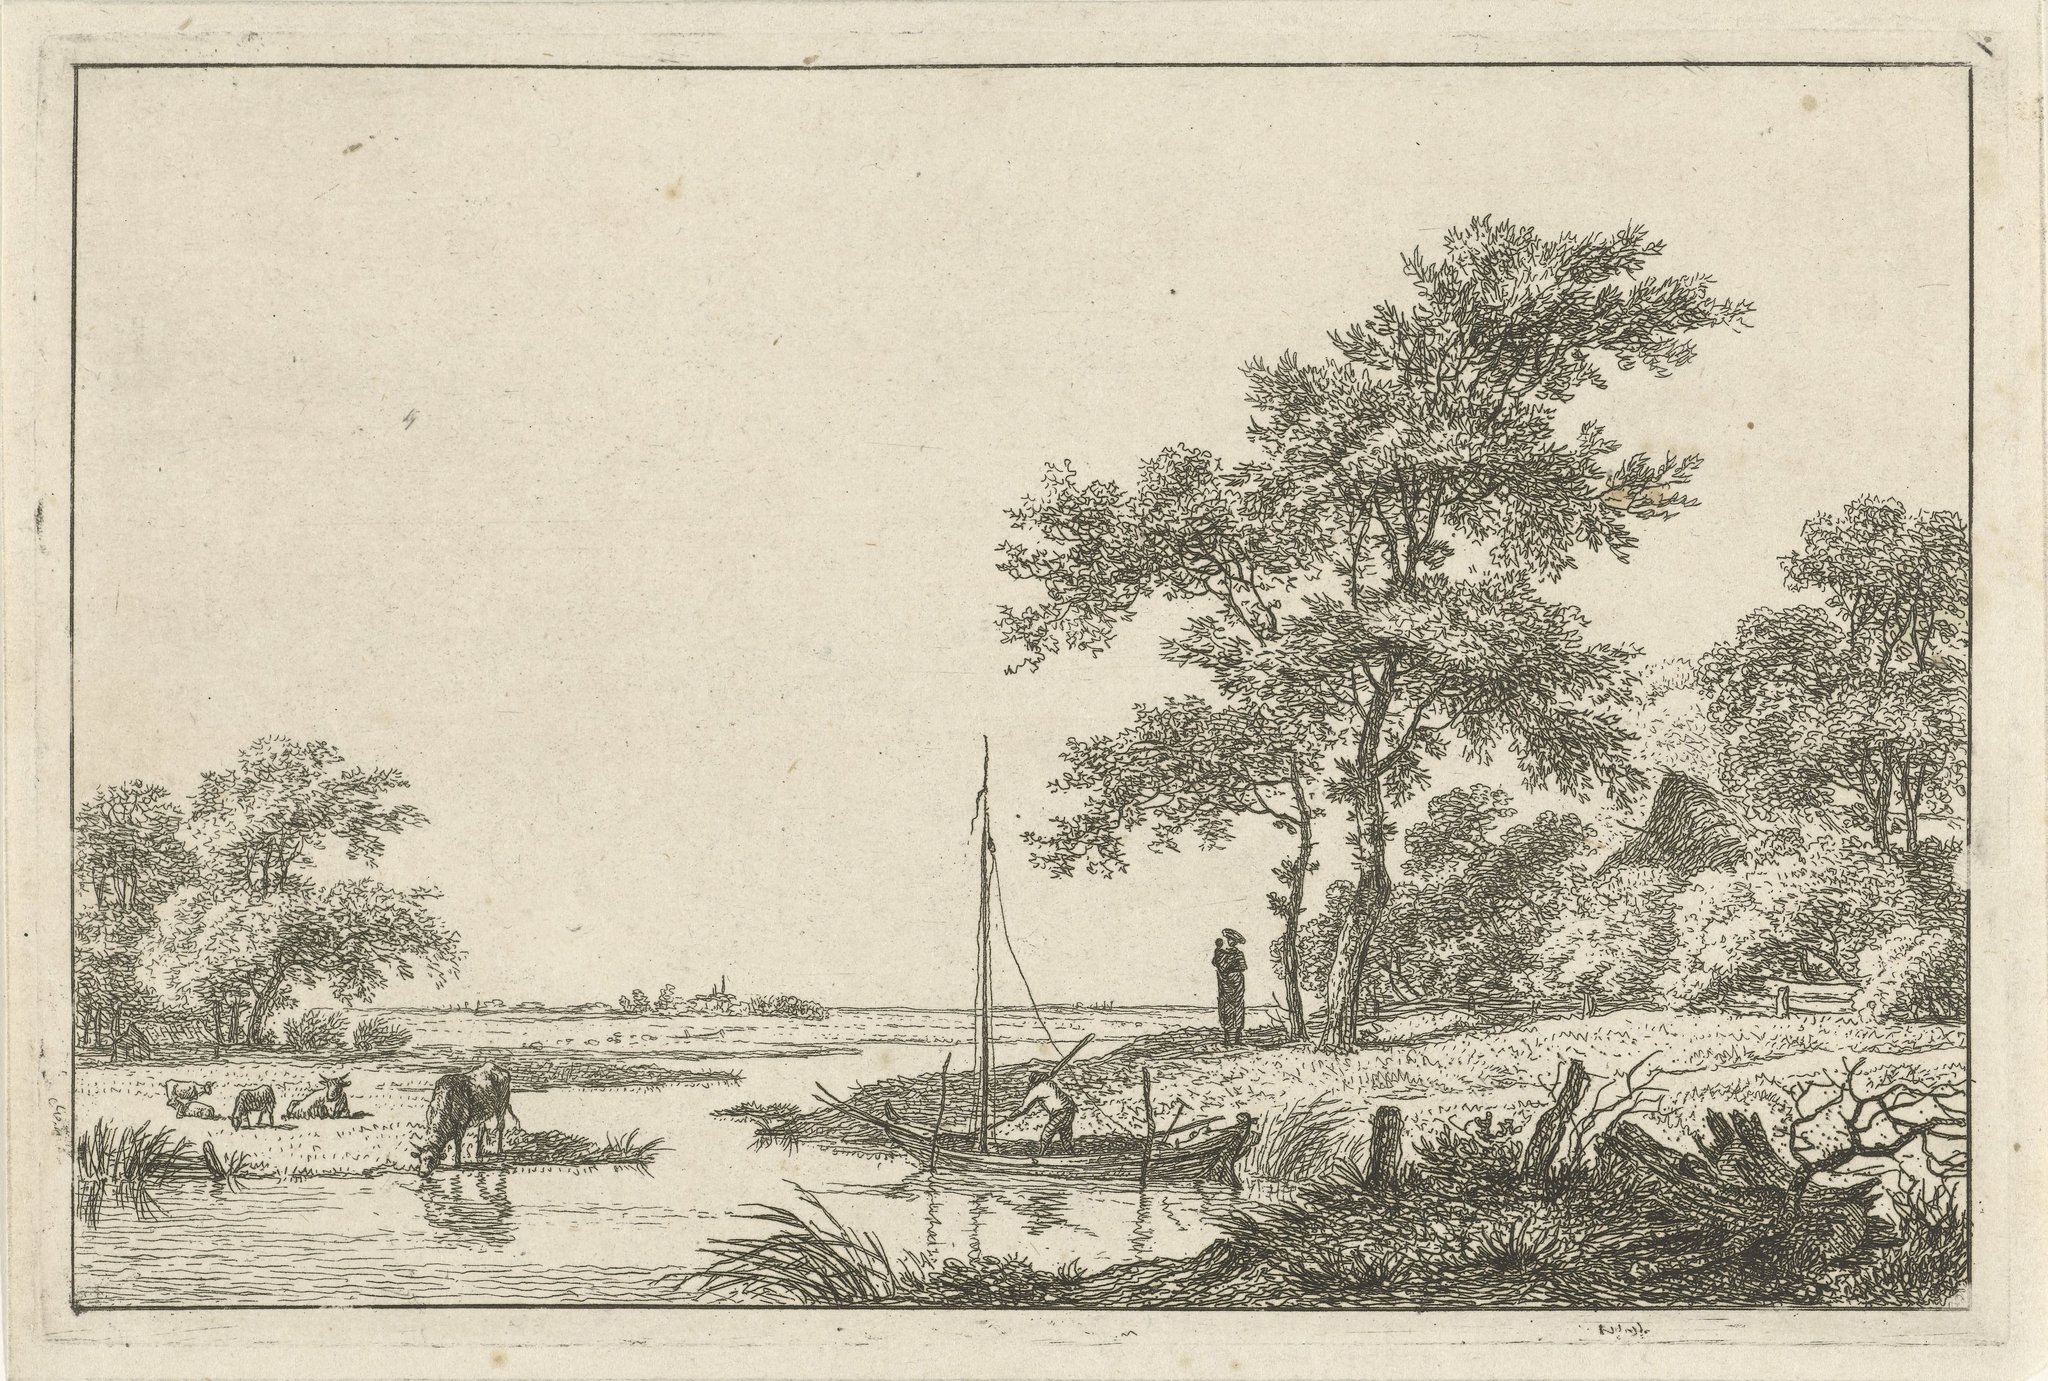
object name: print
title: Landschap met schuitje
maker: hermanus fock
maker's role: conservator, draughtsman, painter, print maker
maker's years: 1766-1822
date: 1781-1822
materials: paper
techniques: etching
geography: amsterdam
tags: river (+ landscape with figures, staffage)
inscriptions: collector's mark: Lugt 2228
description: Een rivierlandschap met koeien en een zeilbootje. Op de oever van de rivier, bij twee bomen, staat een persoon met een kind in de armen. Tussen de bomen op de achtergrond het dak van een boerderij.